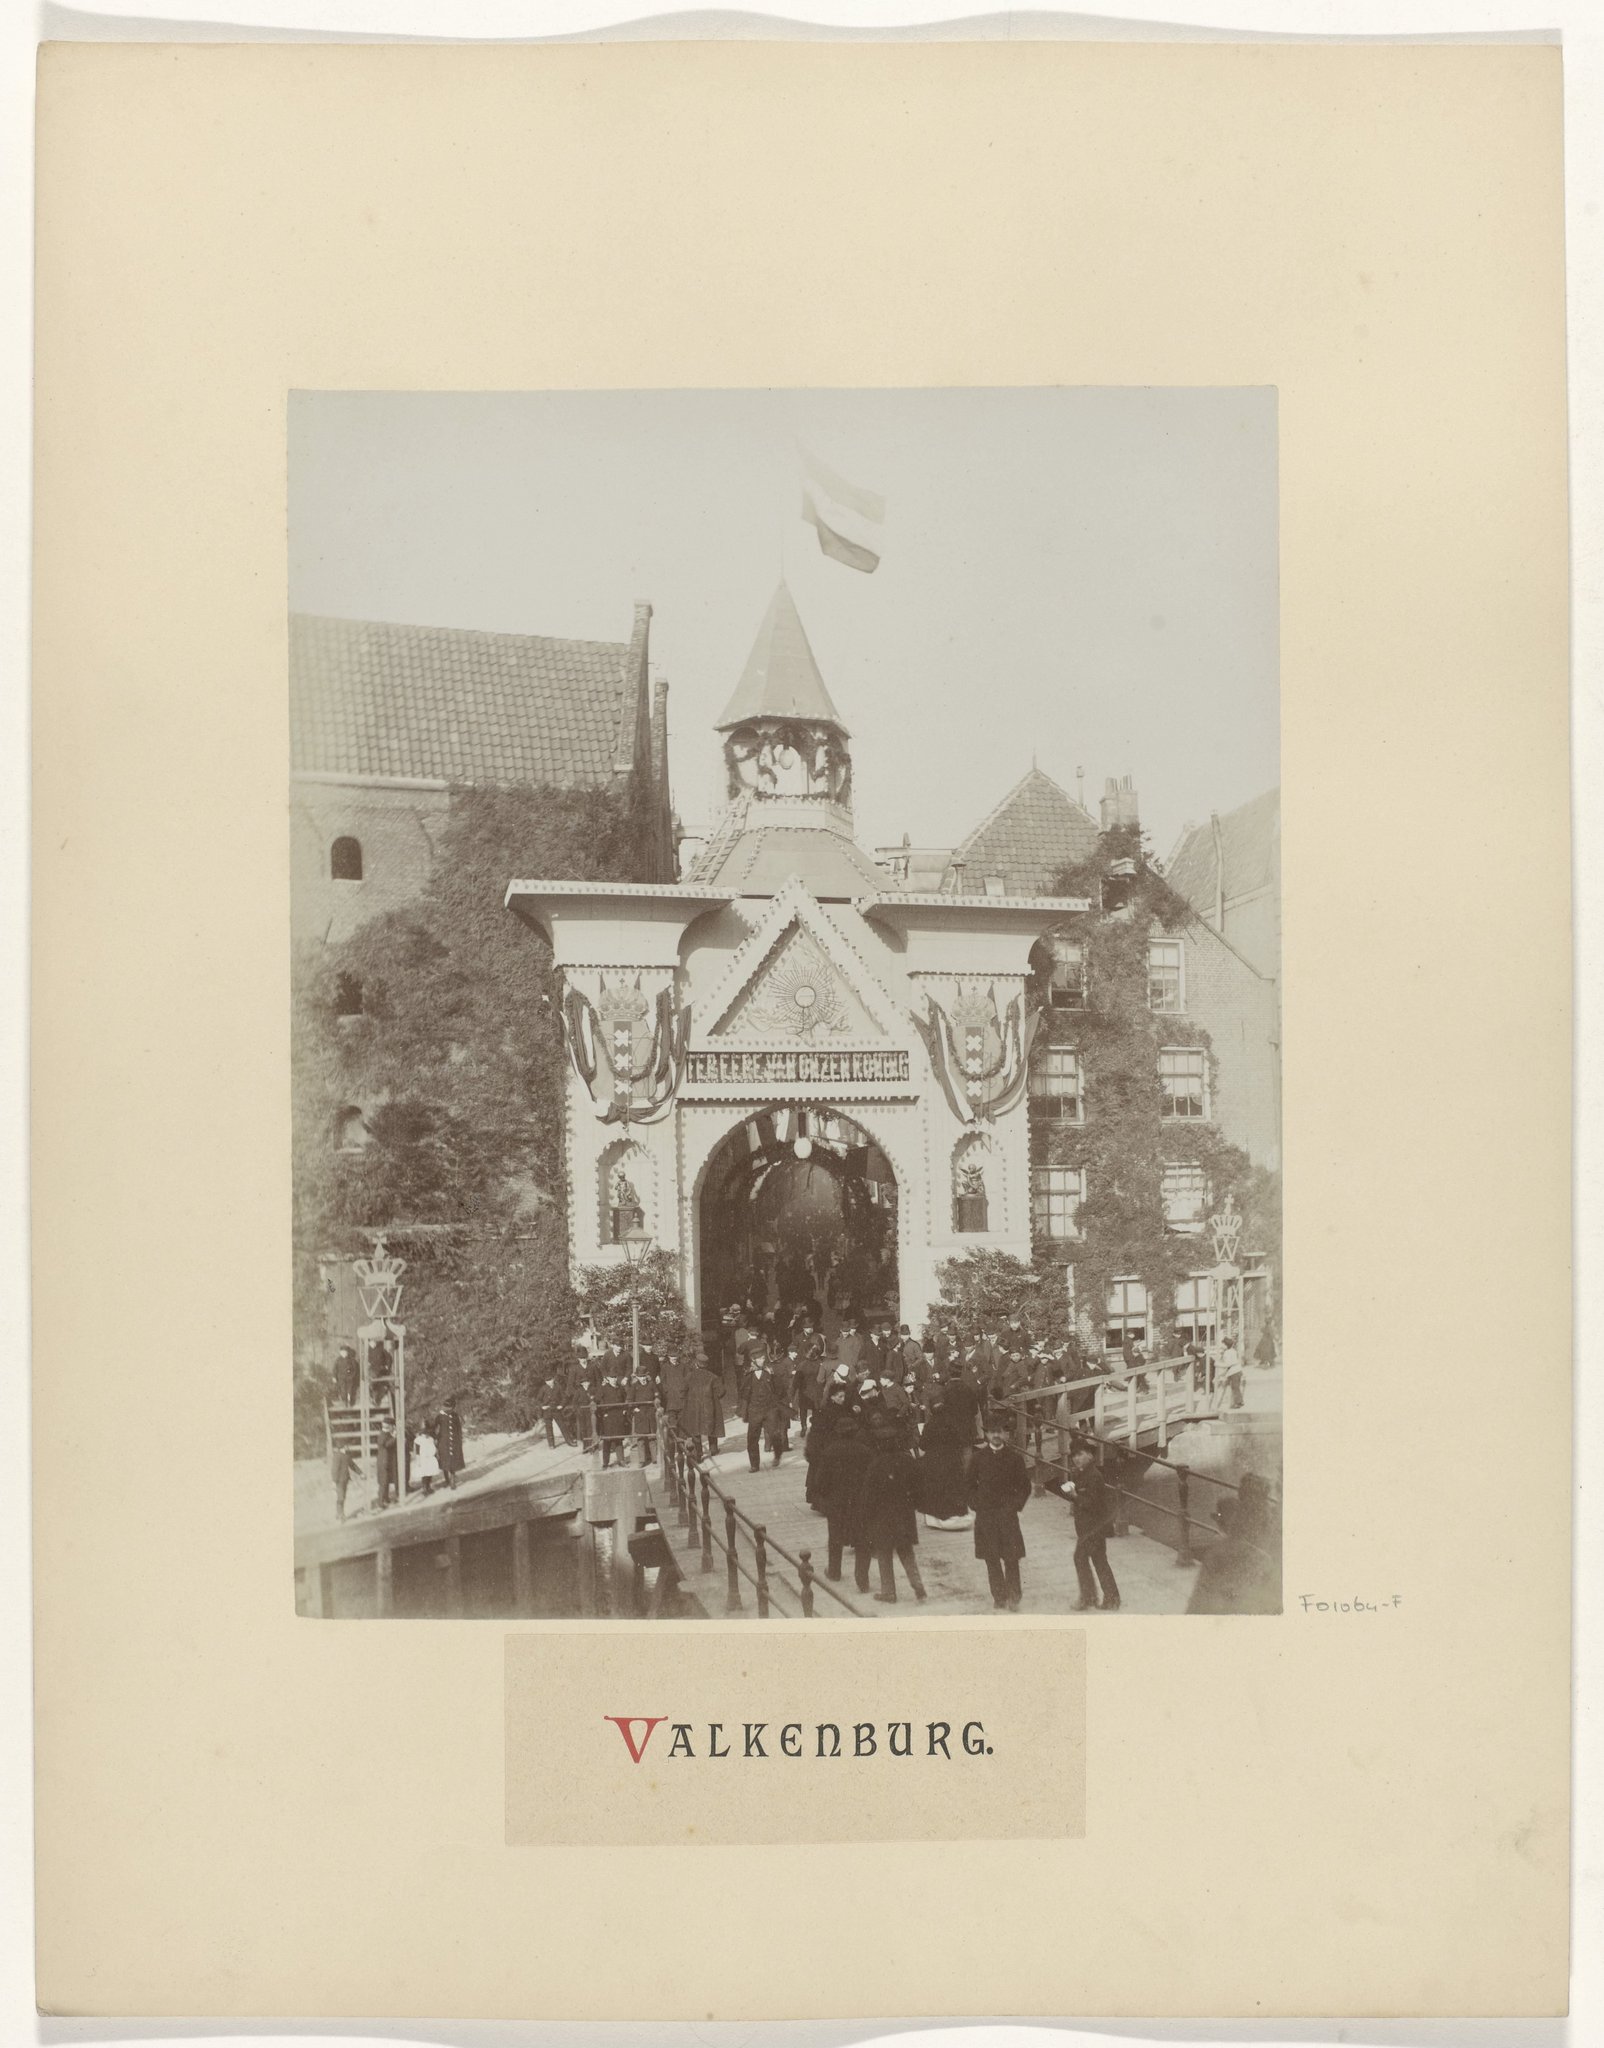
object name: photograph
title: Menigte onder een ereboog op Valkenburg tijdens de Aprilfeesten in 1887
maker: henri de louw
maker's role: fotograaf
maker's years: 1851-1944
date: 1887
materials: cardboard, paper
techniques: albumen print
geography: amsterdam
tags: public festivities on the occasion of royal events, street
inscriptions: inscription: ‘Valkenburg’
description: Deze foto maakt deel uit van een omslag met twaalf foto's.